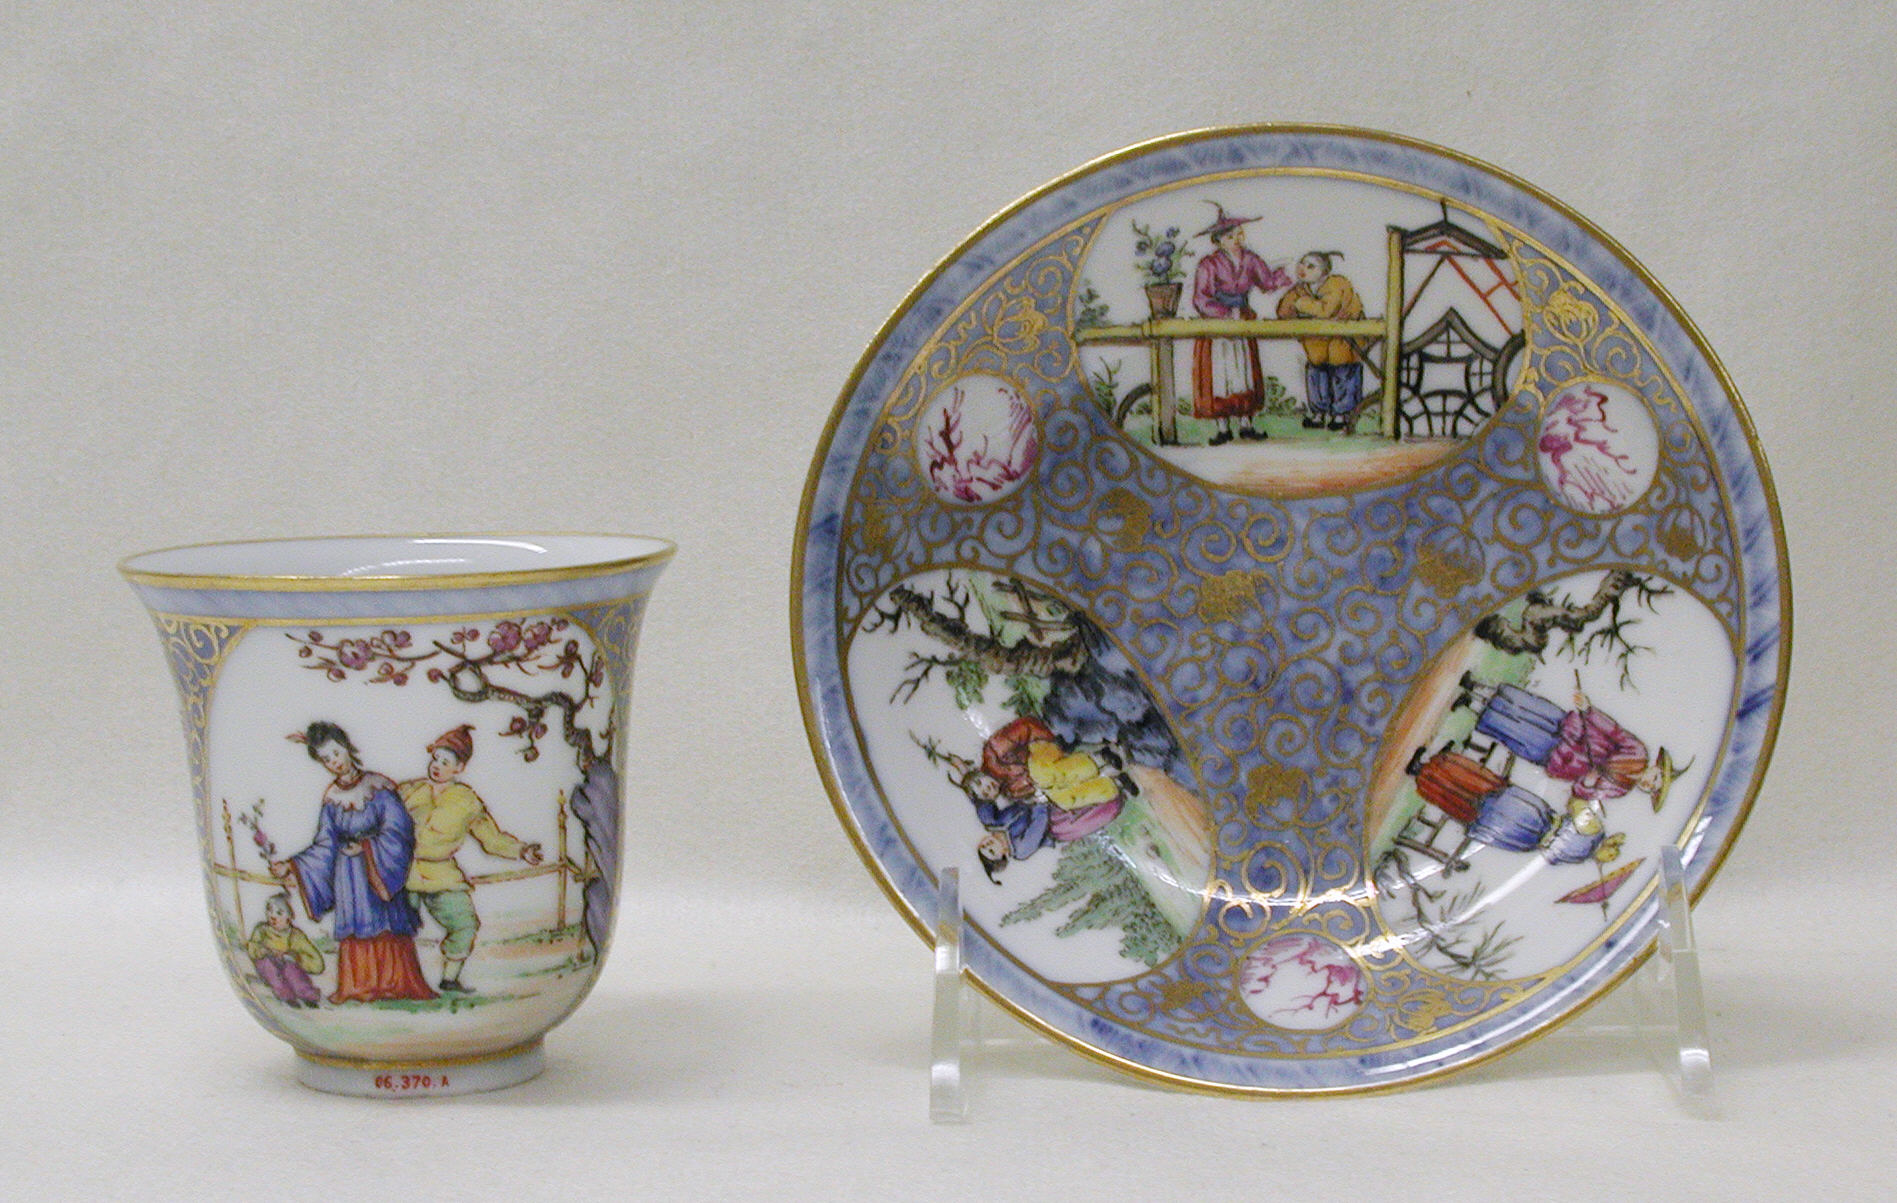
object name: cup and saucer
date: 1801-1900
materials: hard paste porcelain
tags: chinoiserie,men,women